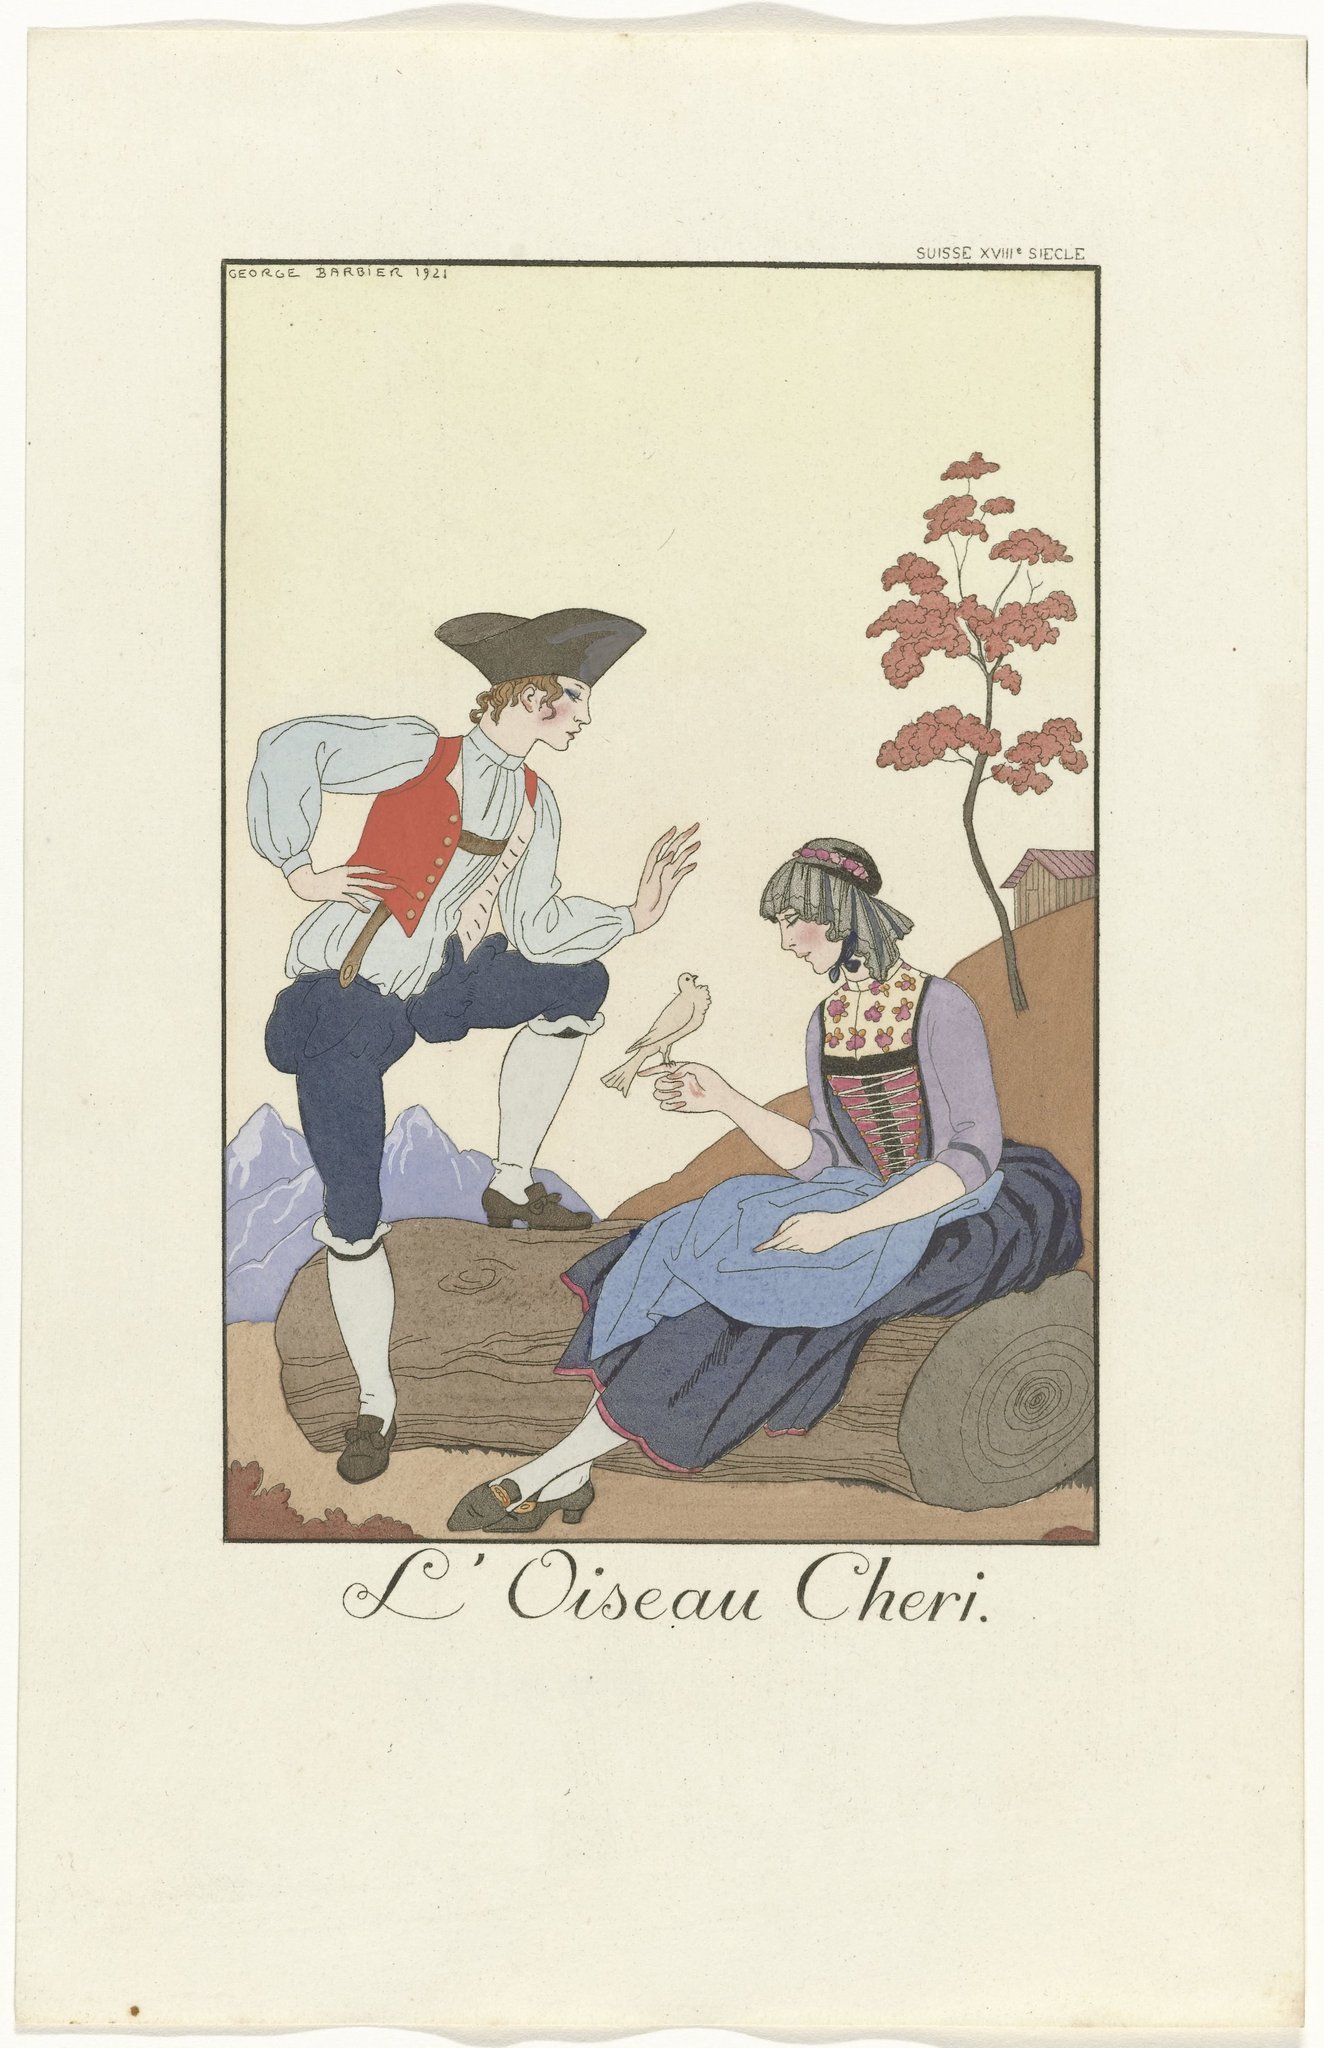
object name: magazine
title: Falbalas et Fanfreluches: almanach des modes présentes, passées & futures pour 1922: L'Oiseau Cheri / Suisse XVIIIe siècle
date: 1921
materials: paper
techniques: hand coloring, lithograph, pochoir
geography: paris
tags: folk costume, regional costume (+ women's clothes), europeans (with name), folk costume, regional costume (+ men's clothes), birds, fashion plates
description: Een jongeman en een meisje in 18de-eeuwse Zwitserse klederdracht, in een landschap met bergen op de achtergrond. Het meisje heeft een vogel op de hand. Prent uit de serie Falbalas & Fanfreluches (1922-1926).